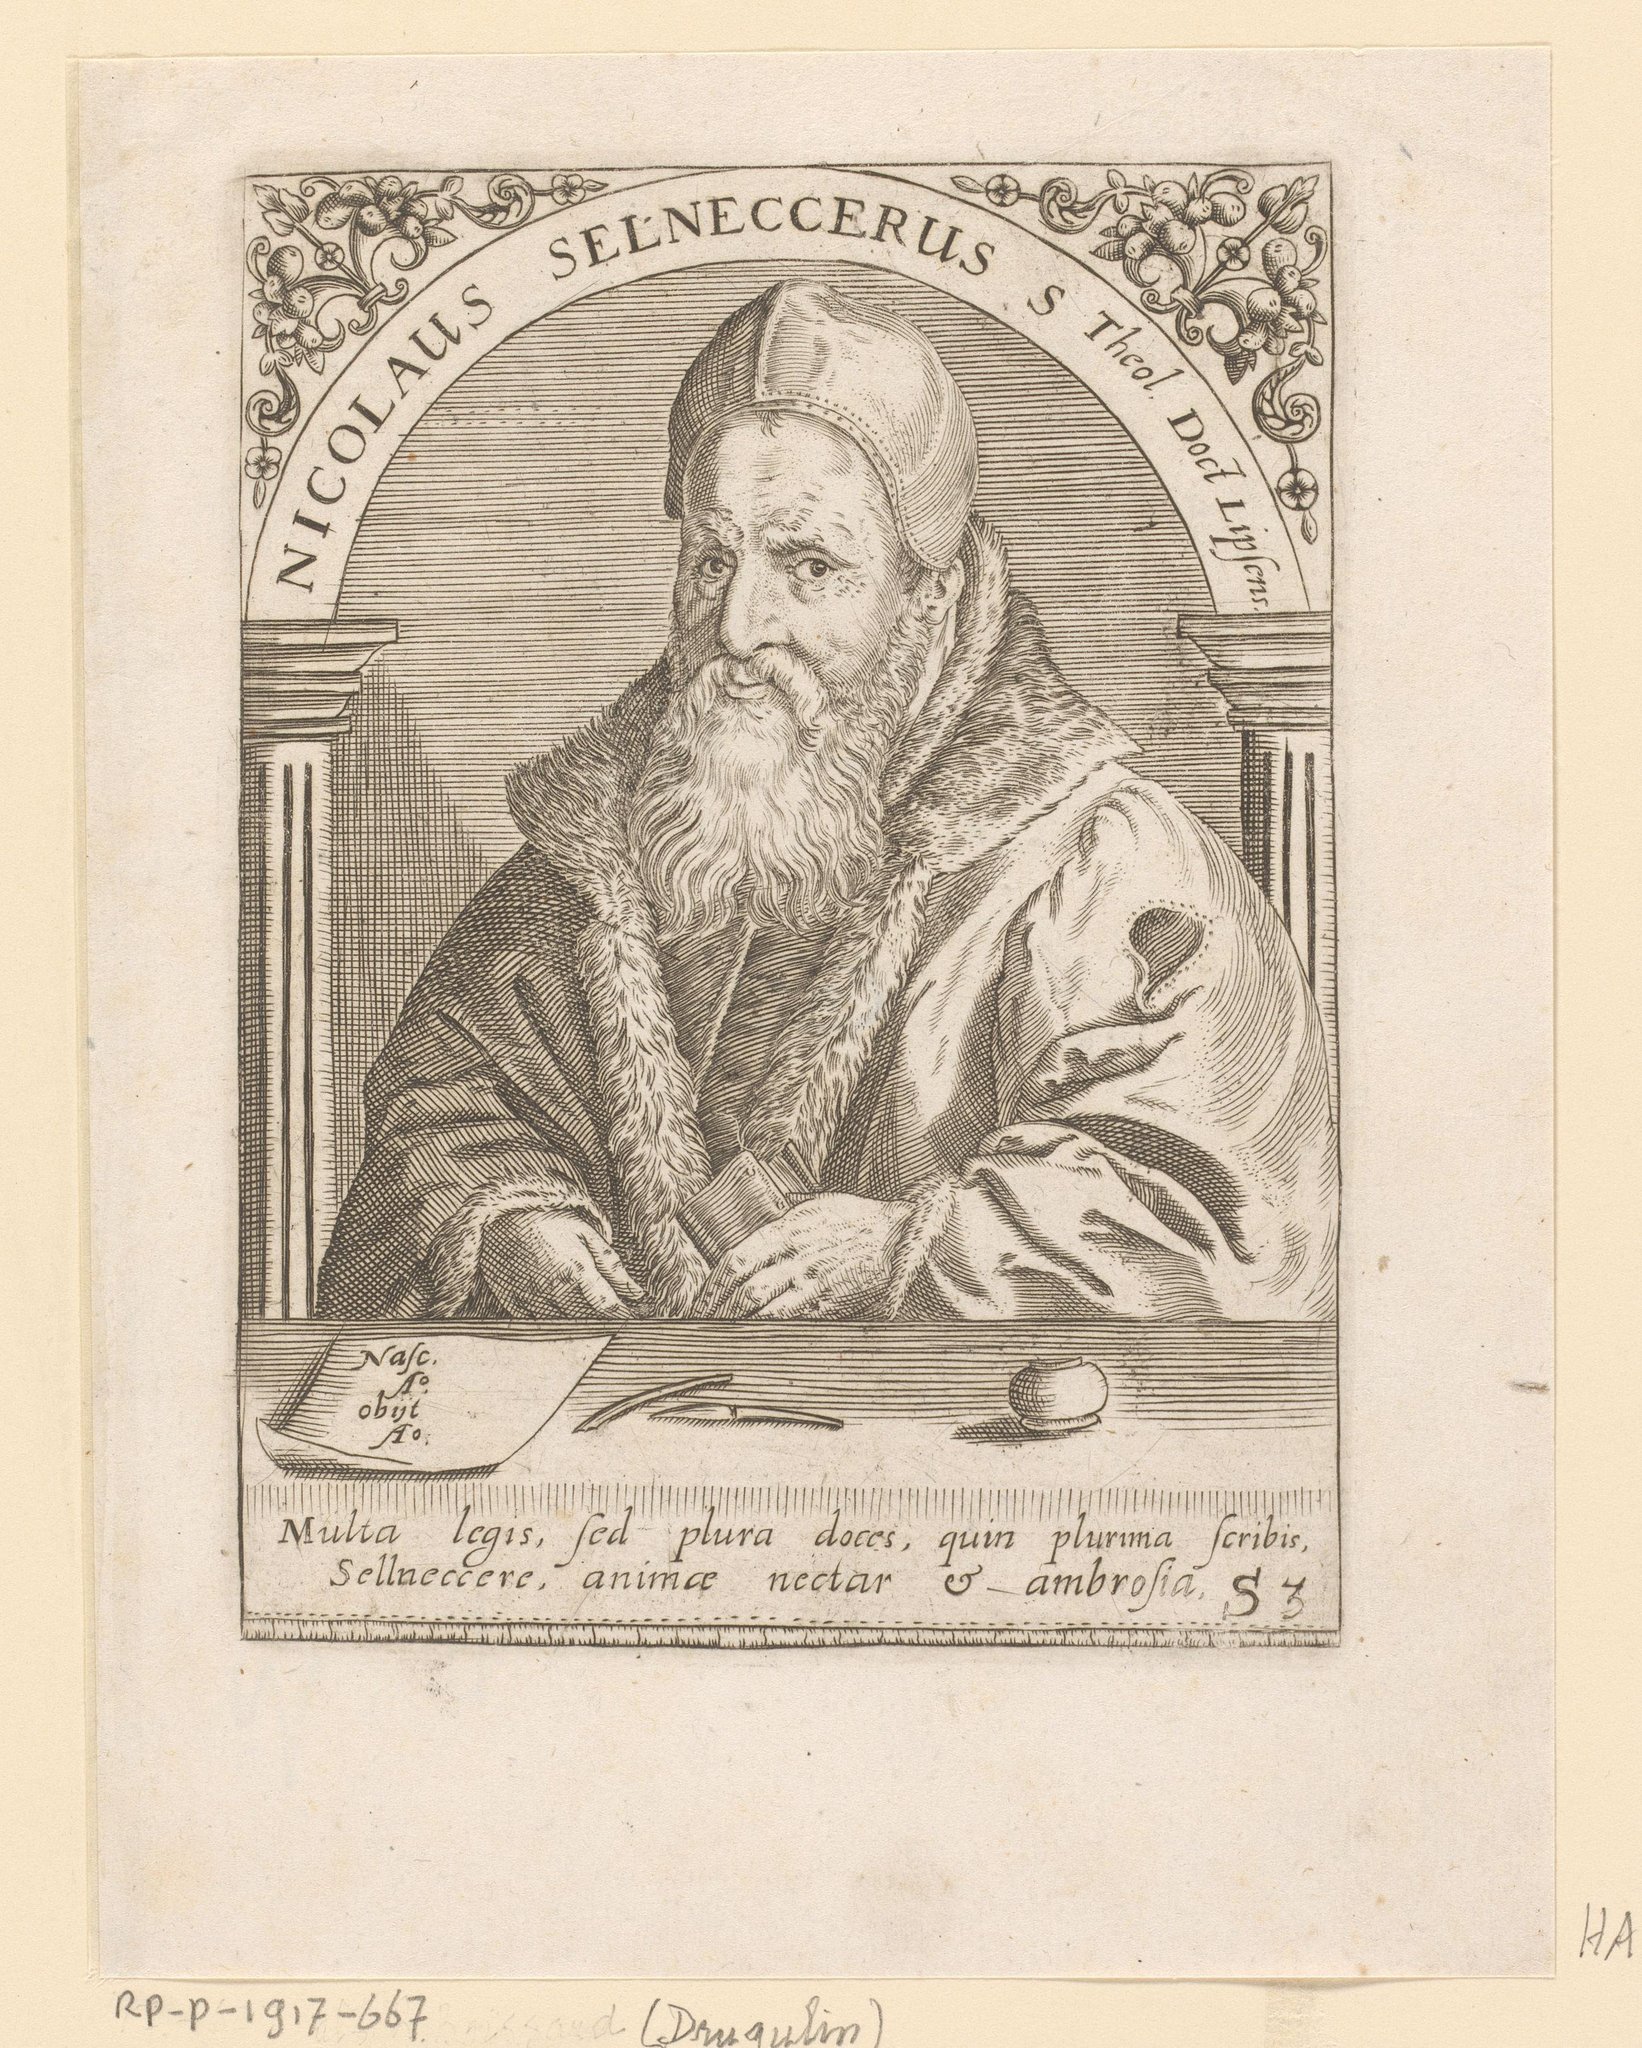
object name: print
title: Portret van Nikolaus Selnecker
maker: jean jacques boissard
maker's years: 1528-1598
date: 1650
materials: paper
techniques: engraving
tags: theologian, historical persons, portrait of a musician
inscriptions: collector's mark: Lugt 2228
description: Prent gebruikt in: Boissard, Jean Jacques. Bibliotheca chalcographica. 8 dln. Frankfurt am Main: Johannes Ammon, 1650-1652. Ook gebruikt in latere edities. Eerdere staat van prent verschenen in: Boissard, Jean Jacques. Icones quinquaginta virorum illustrium doctrina & eruditione praestantium ad vivum effictae. 4 dln. Frankfurt am Main: s.n., 1597-1599. Mogelijk ook gebruikt in latere edities.